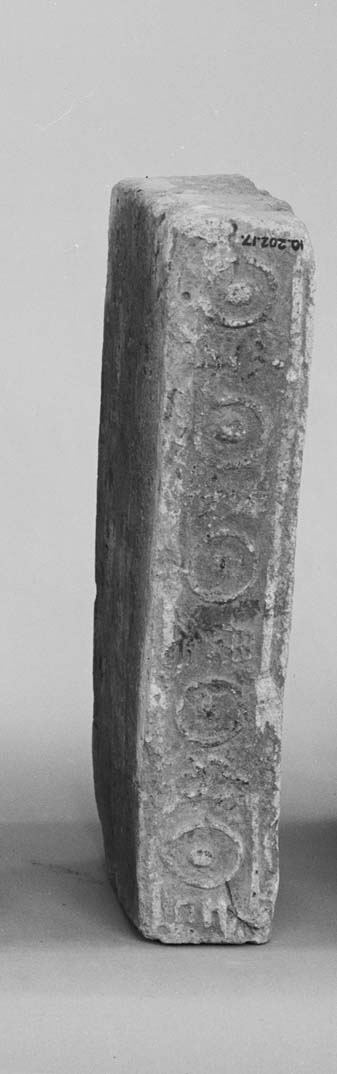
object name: tile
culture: chinese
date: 221 BCE-220 CE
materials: earthenware